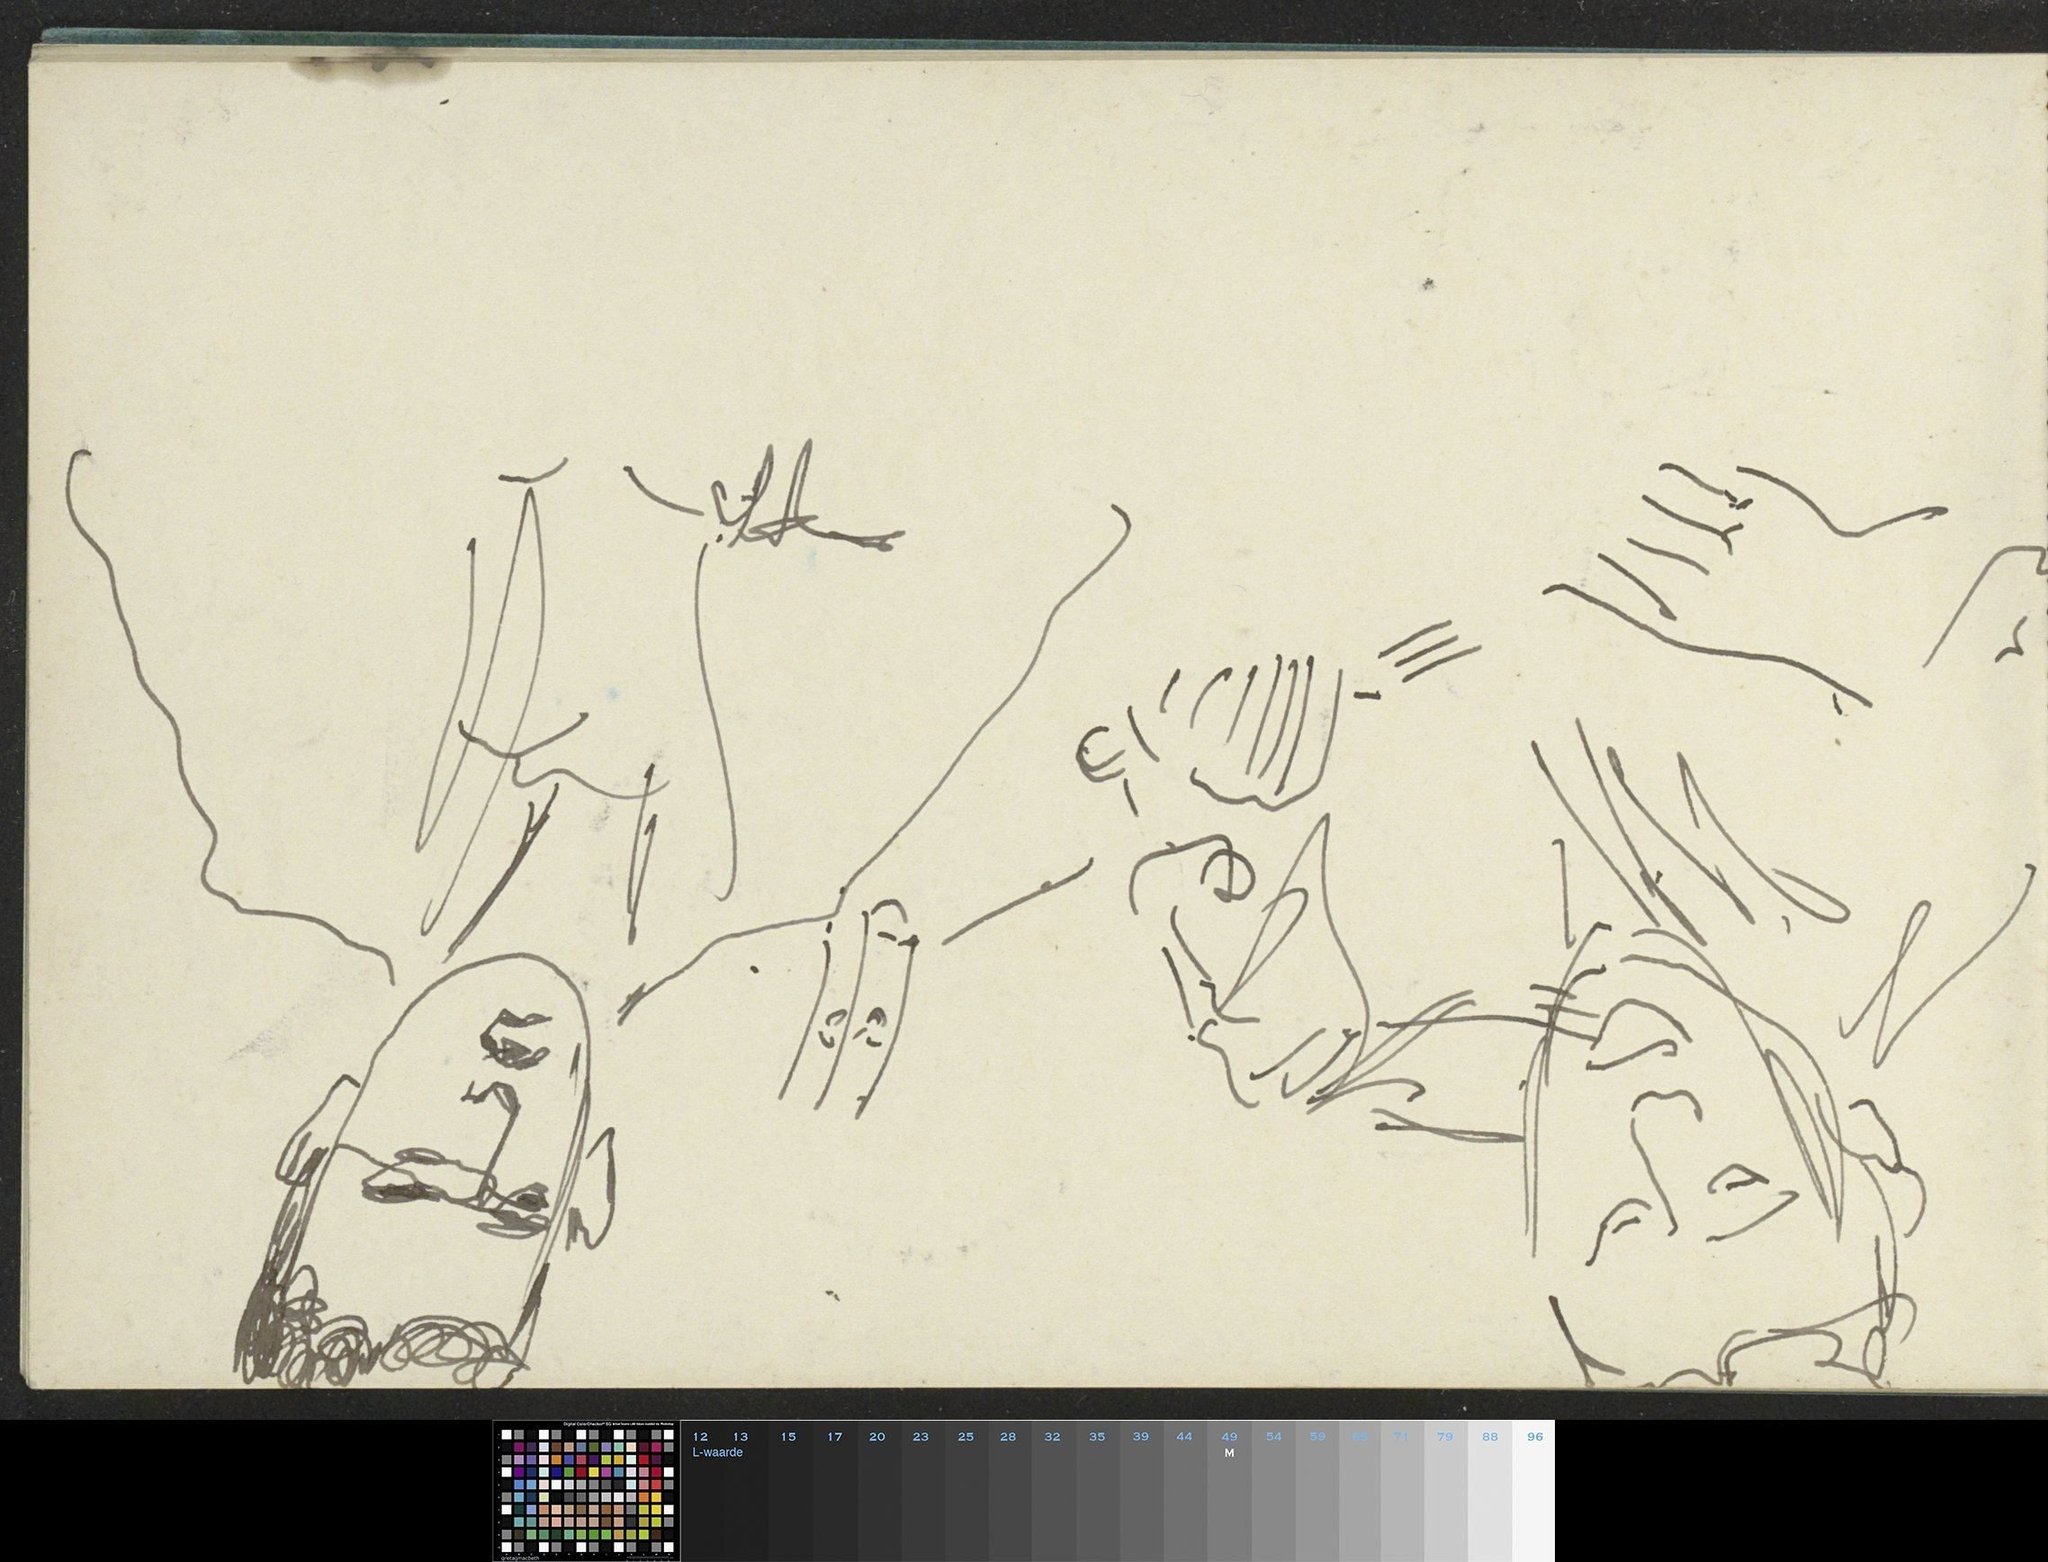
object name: sketchbook leaf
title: Twee mannen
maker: carel adolph lion cachet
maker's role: draughtsman, print maker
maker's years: 1864-1945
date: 1930-1938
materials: ink, paper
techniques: pen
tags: adult man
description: Eén van de mannen heeft zijn handen voor zich op tafel gelegd. Blad 4 verso uit een schetsboek met 9 bladen.